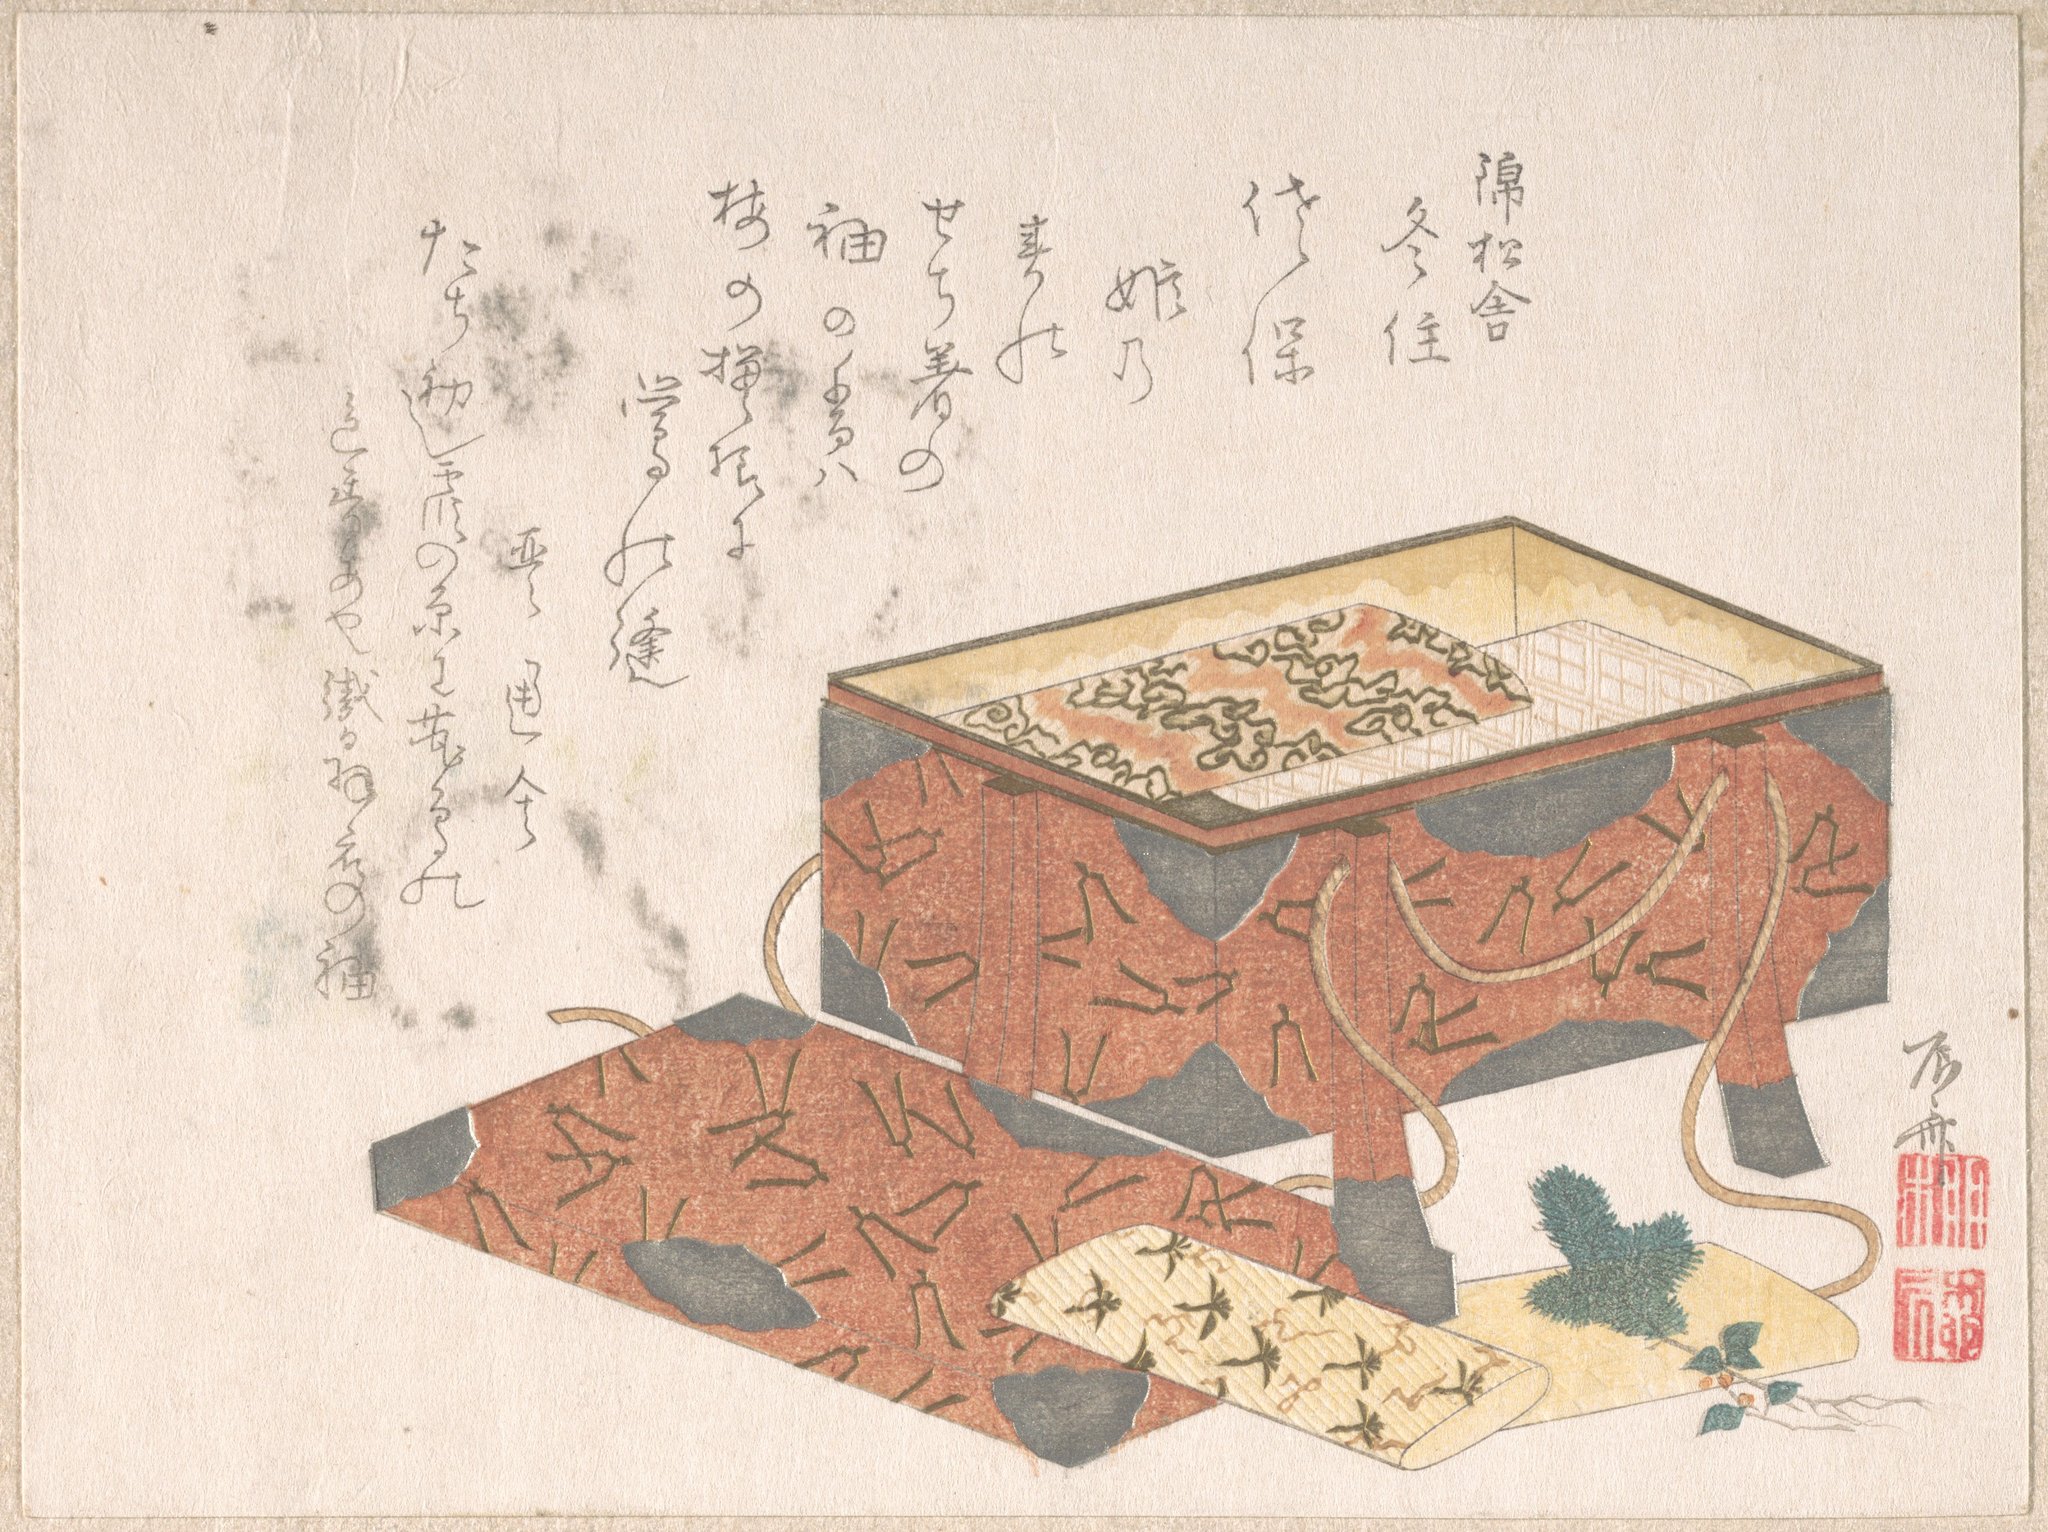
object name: woodblock print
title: Lacquer Box for Clothes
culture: japanese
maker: ryūryūkyo shinsai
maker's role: artist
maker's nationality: japanese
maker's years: 1799-1823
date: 1801-1900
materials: ink, paper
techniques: surimono, woodblock print